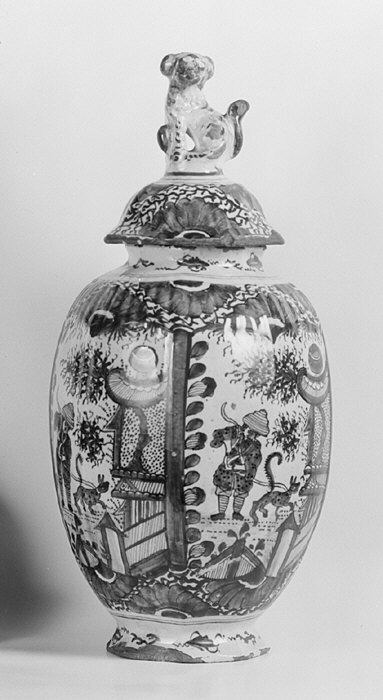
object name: jar with cover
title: Jar with cover (part of a garniture)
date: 1701-1800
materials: earthenware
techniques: glazing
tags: animals,men